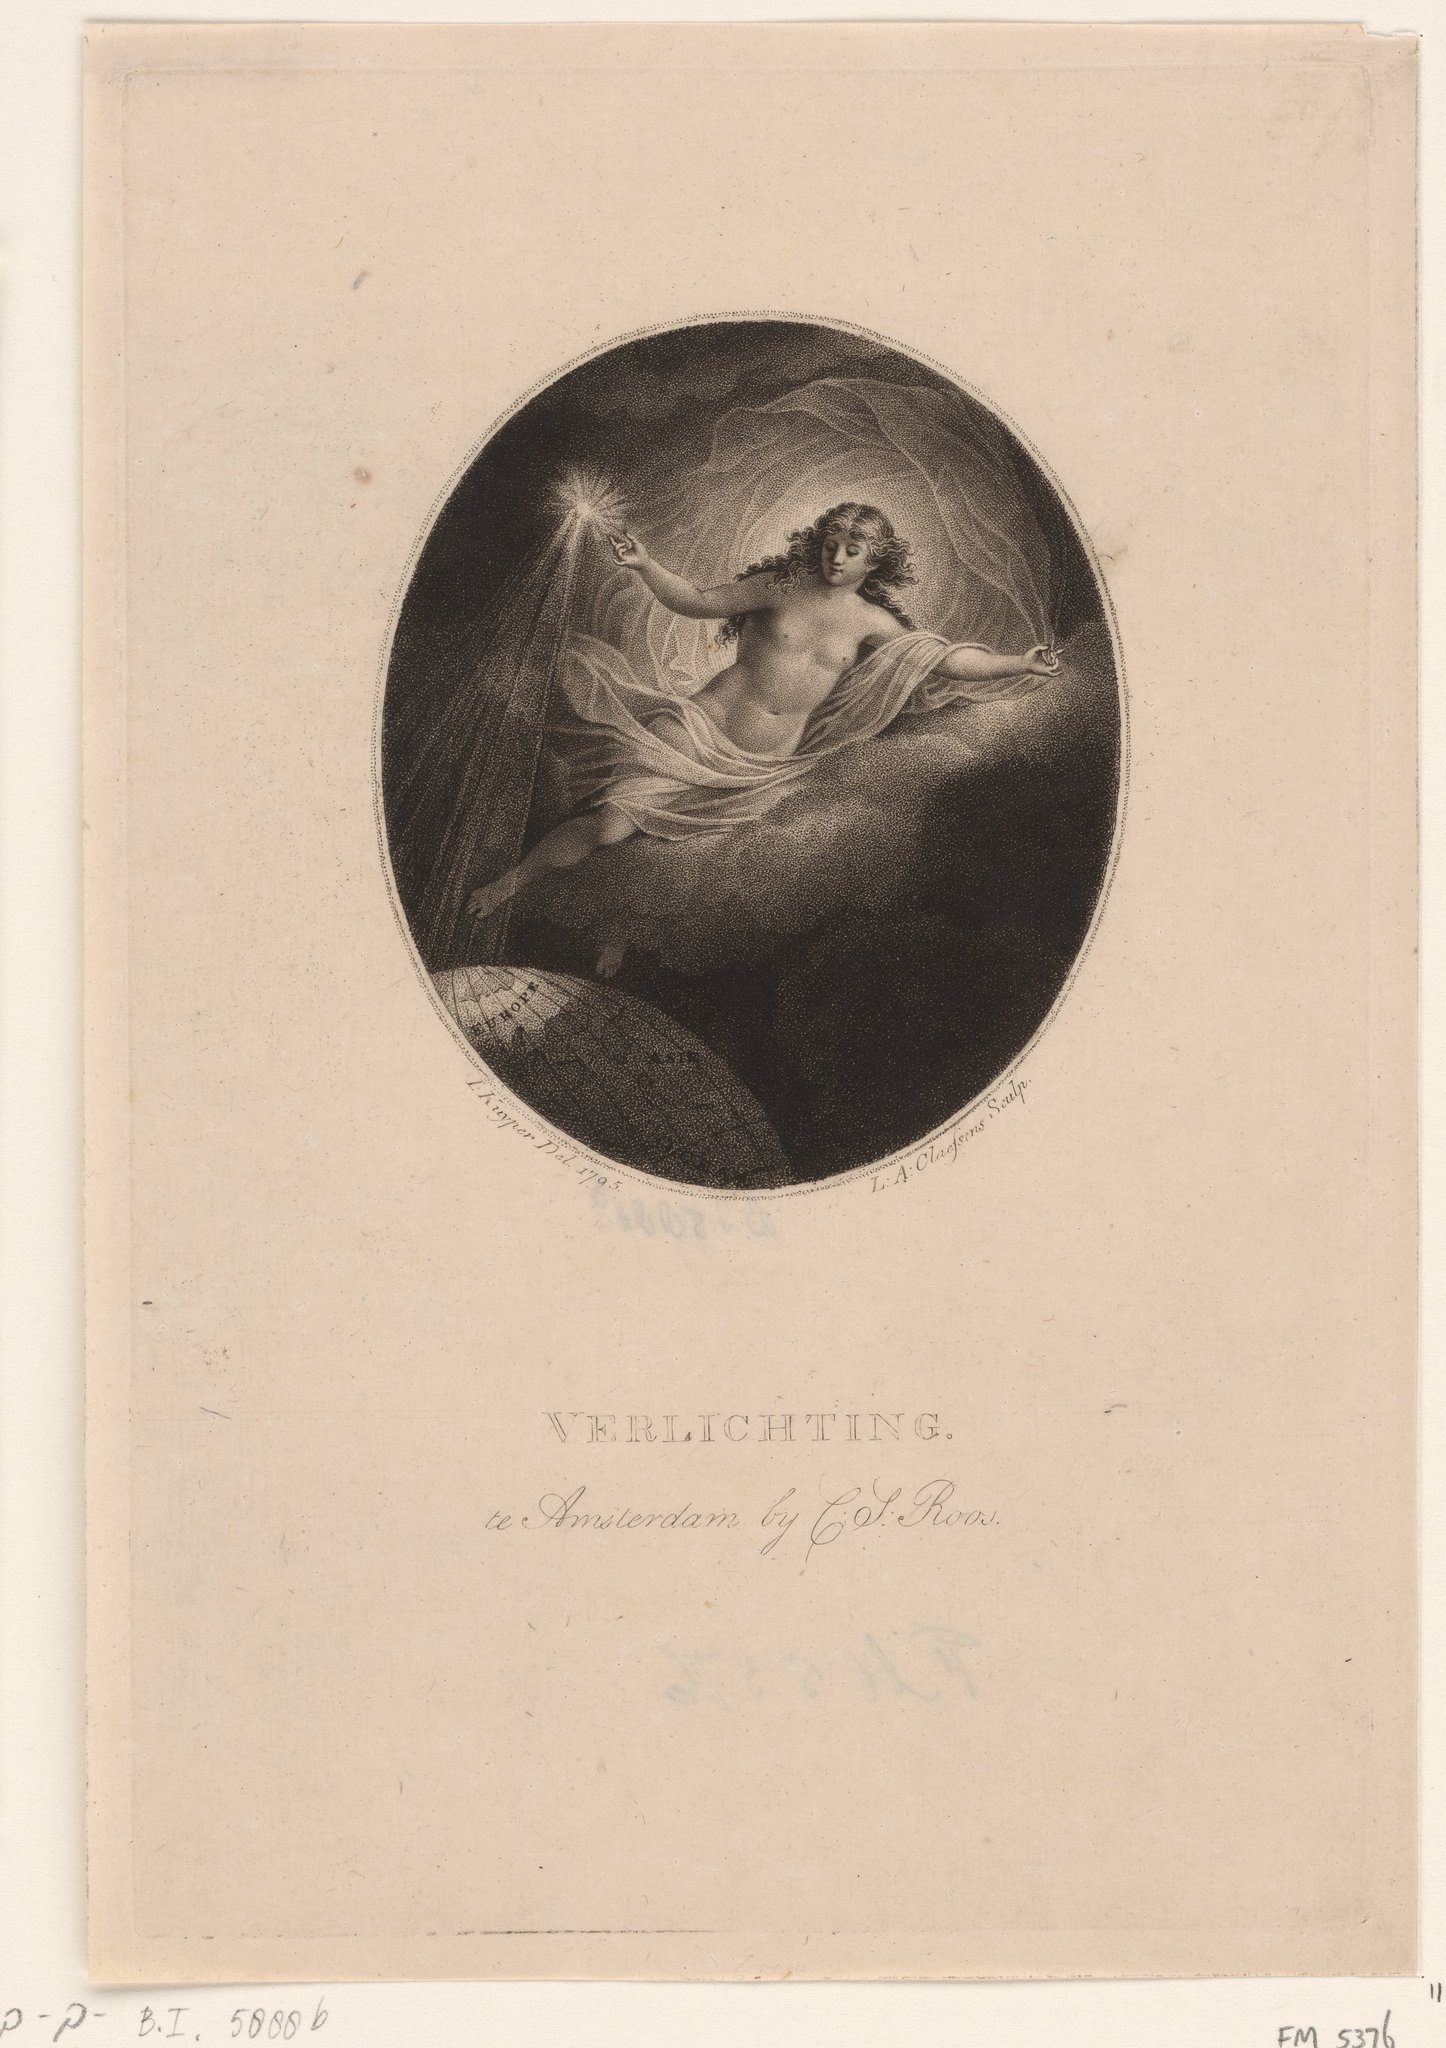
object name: print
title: Verlichting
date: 1795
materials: paper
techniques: etching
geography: amsterdam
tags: lightness; 'leggierezza' (ripa), light shining out of the heavens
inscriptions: collector's mark: Lugt 2228, collector's mark: Lugt 2135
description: De personificatie van de verlichting laat haar licht schijnen op Europa.